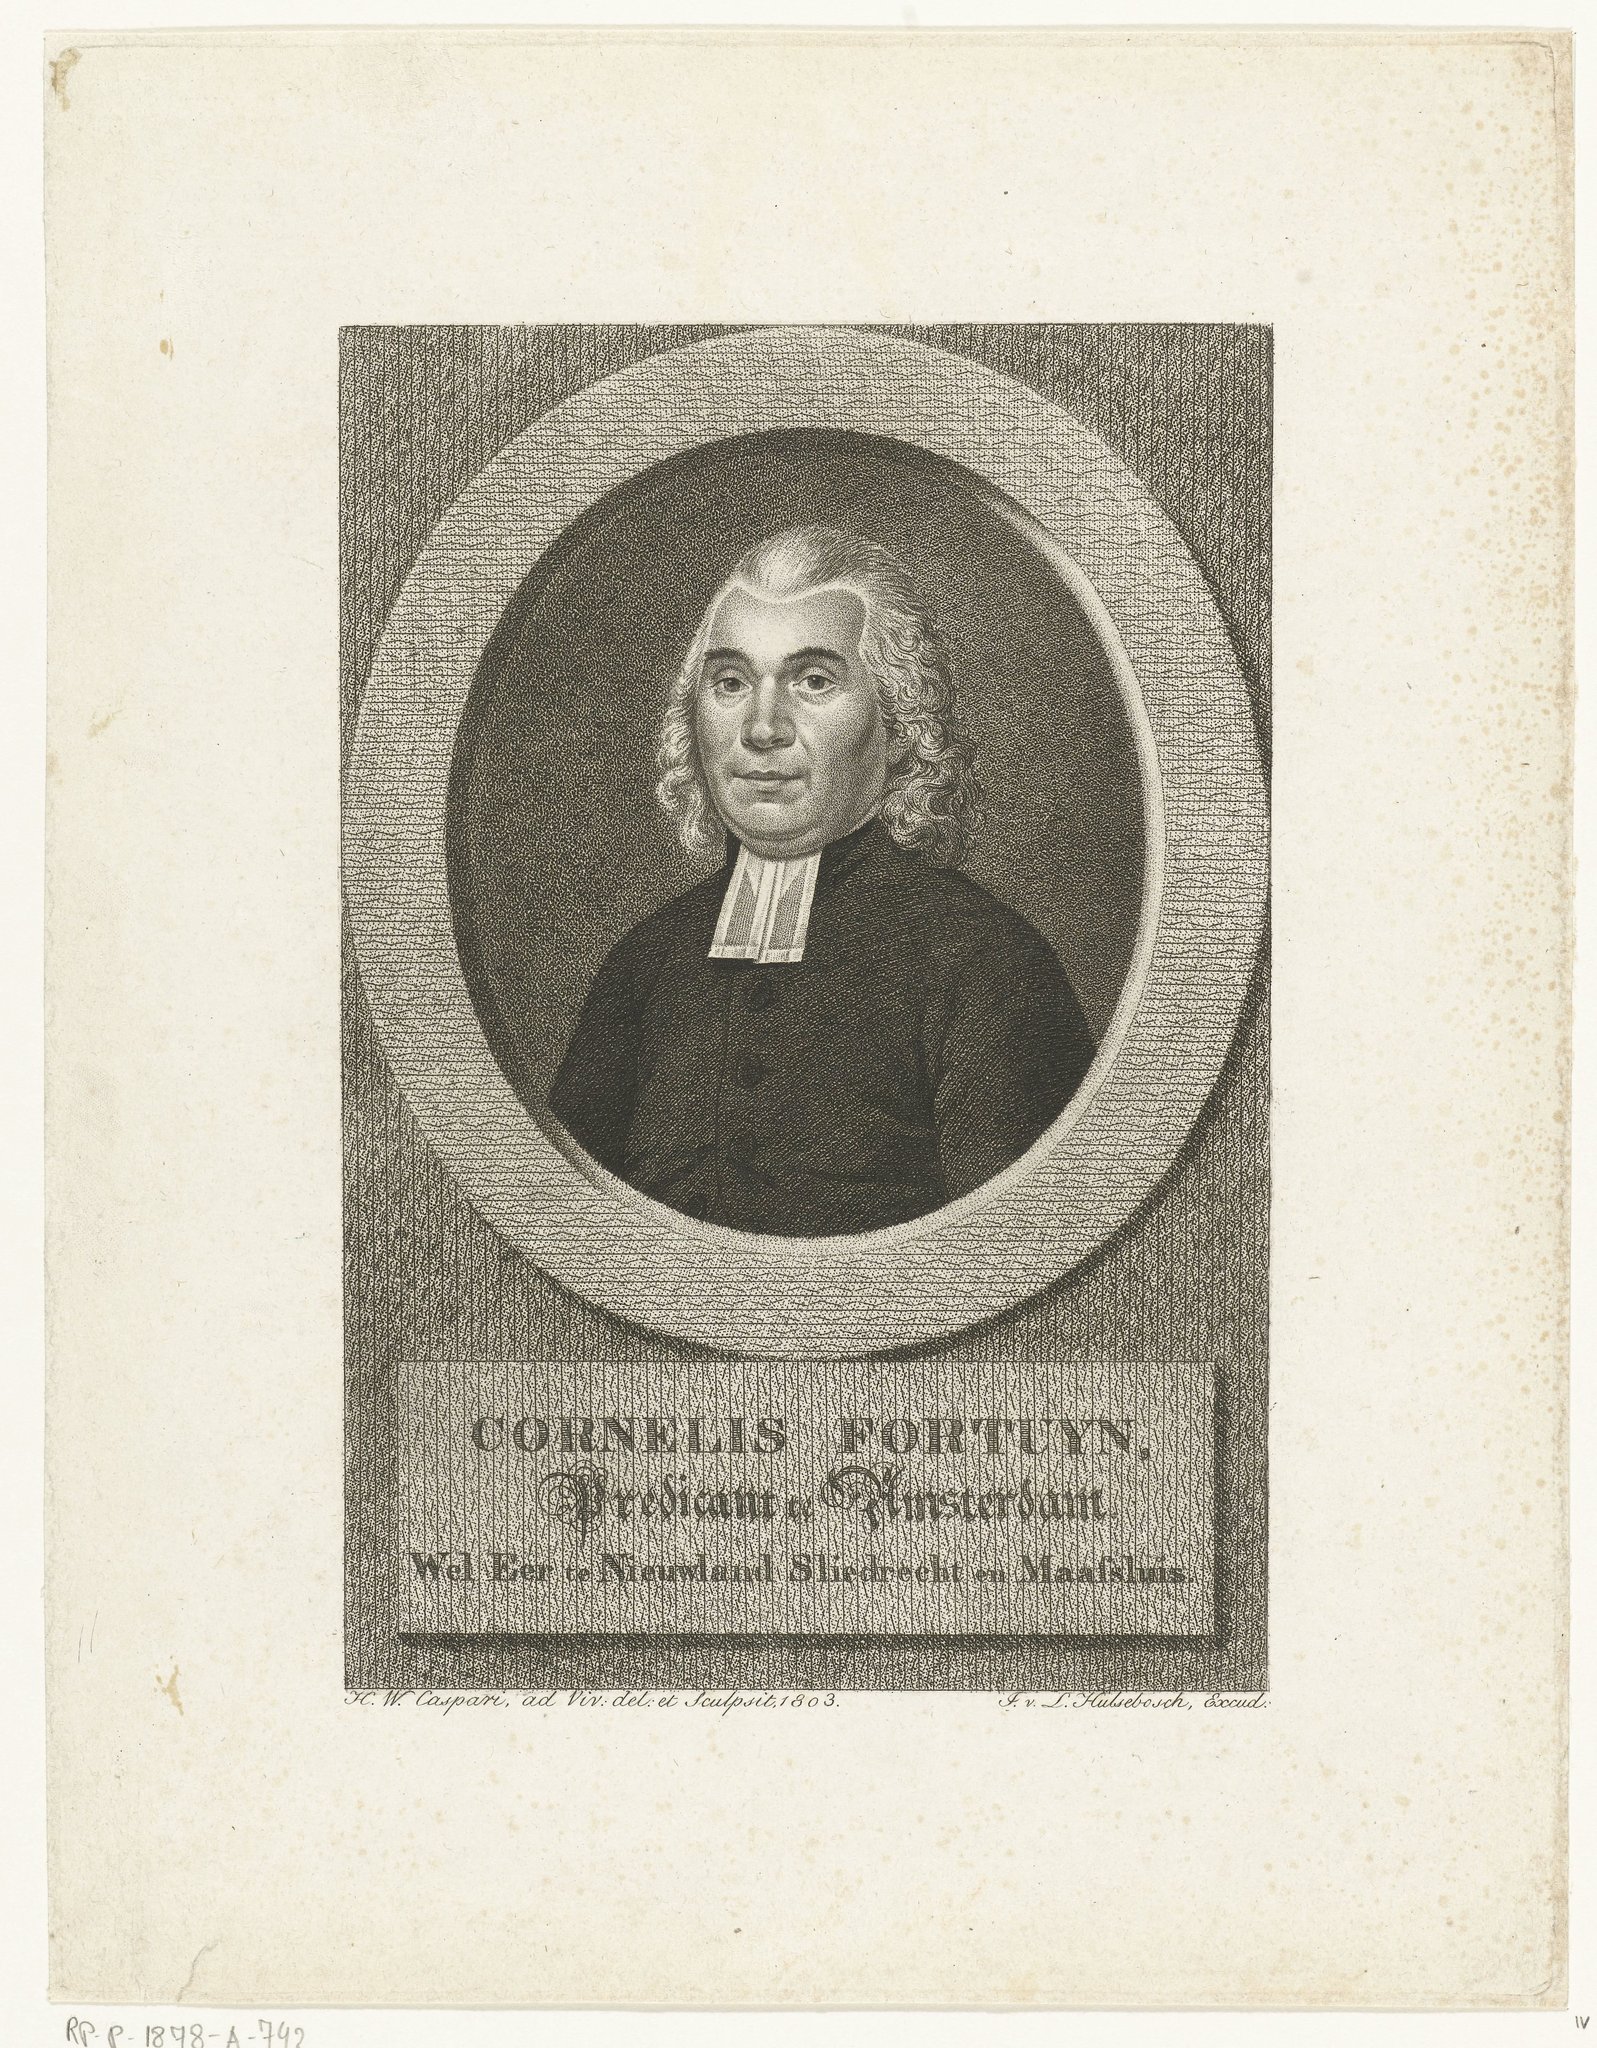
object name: print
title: Portret van Cornelis Fortuyn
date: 1803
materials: paper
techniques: etching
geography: amsterdam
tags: prediker, cornelis fortuyn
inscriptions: collector's mark: Lugt 2228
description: Portret in ovale lijst van Cornelis Fortuyn, een Amsterdamse prediker. Buste naar links. Fortuyn draagt een predikersgewaad. De prent heeft een Nederlands onderschrift met de naam van de geportretteerde.